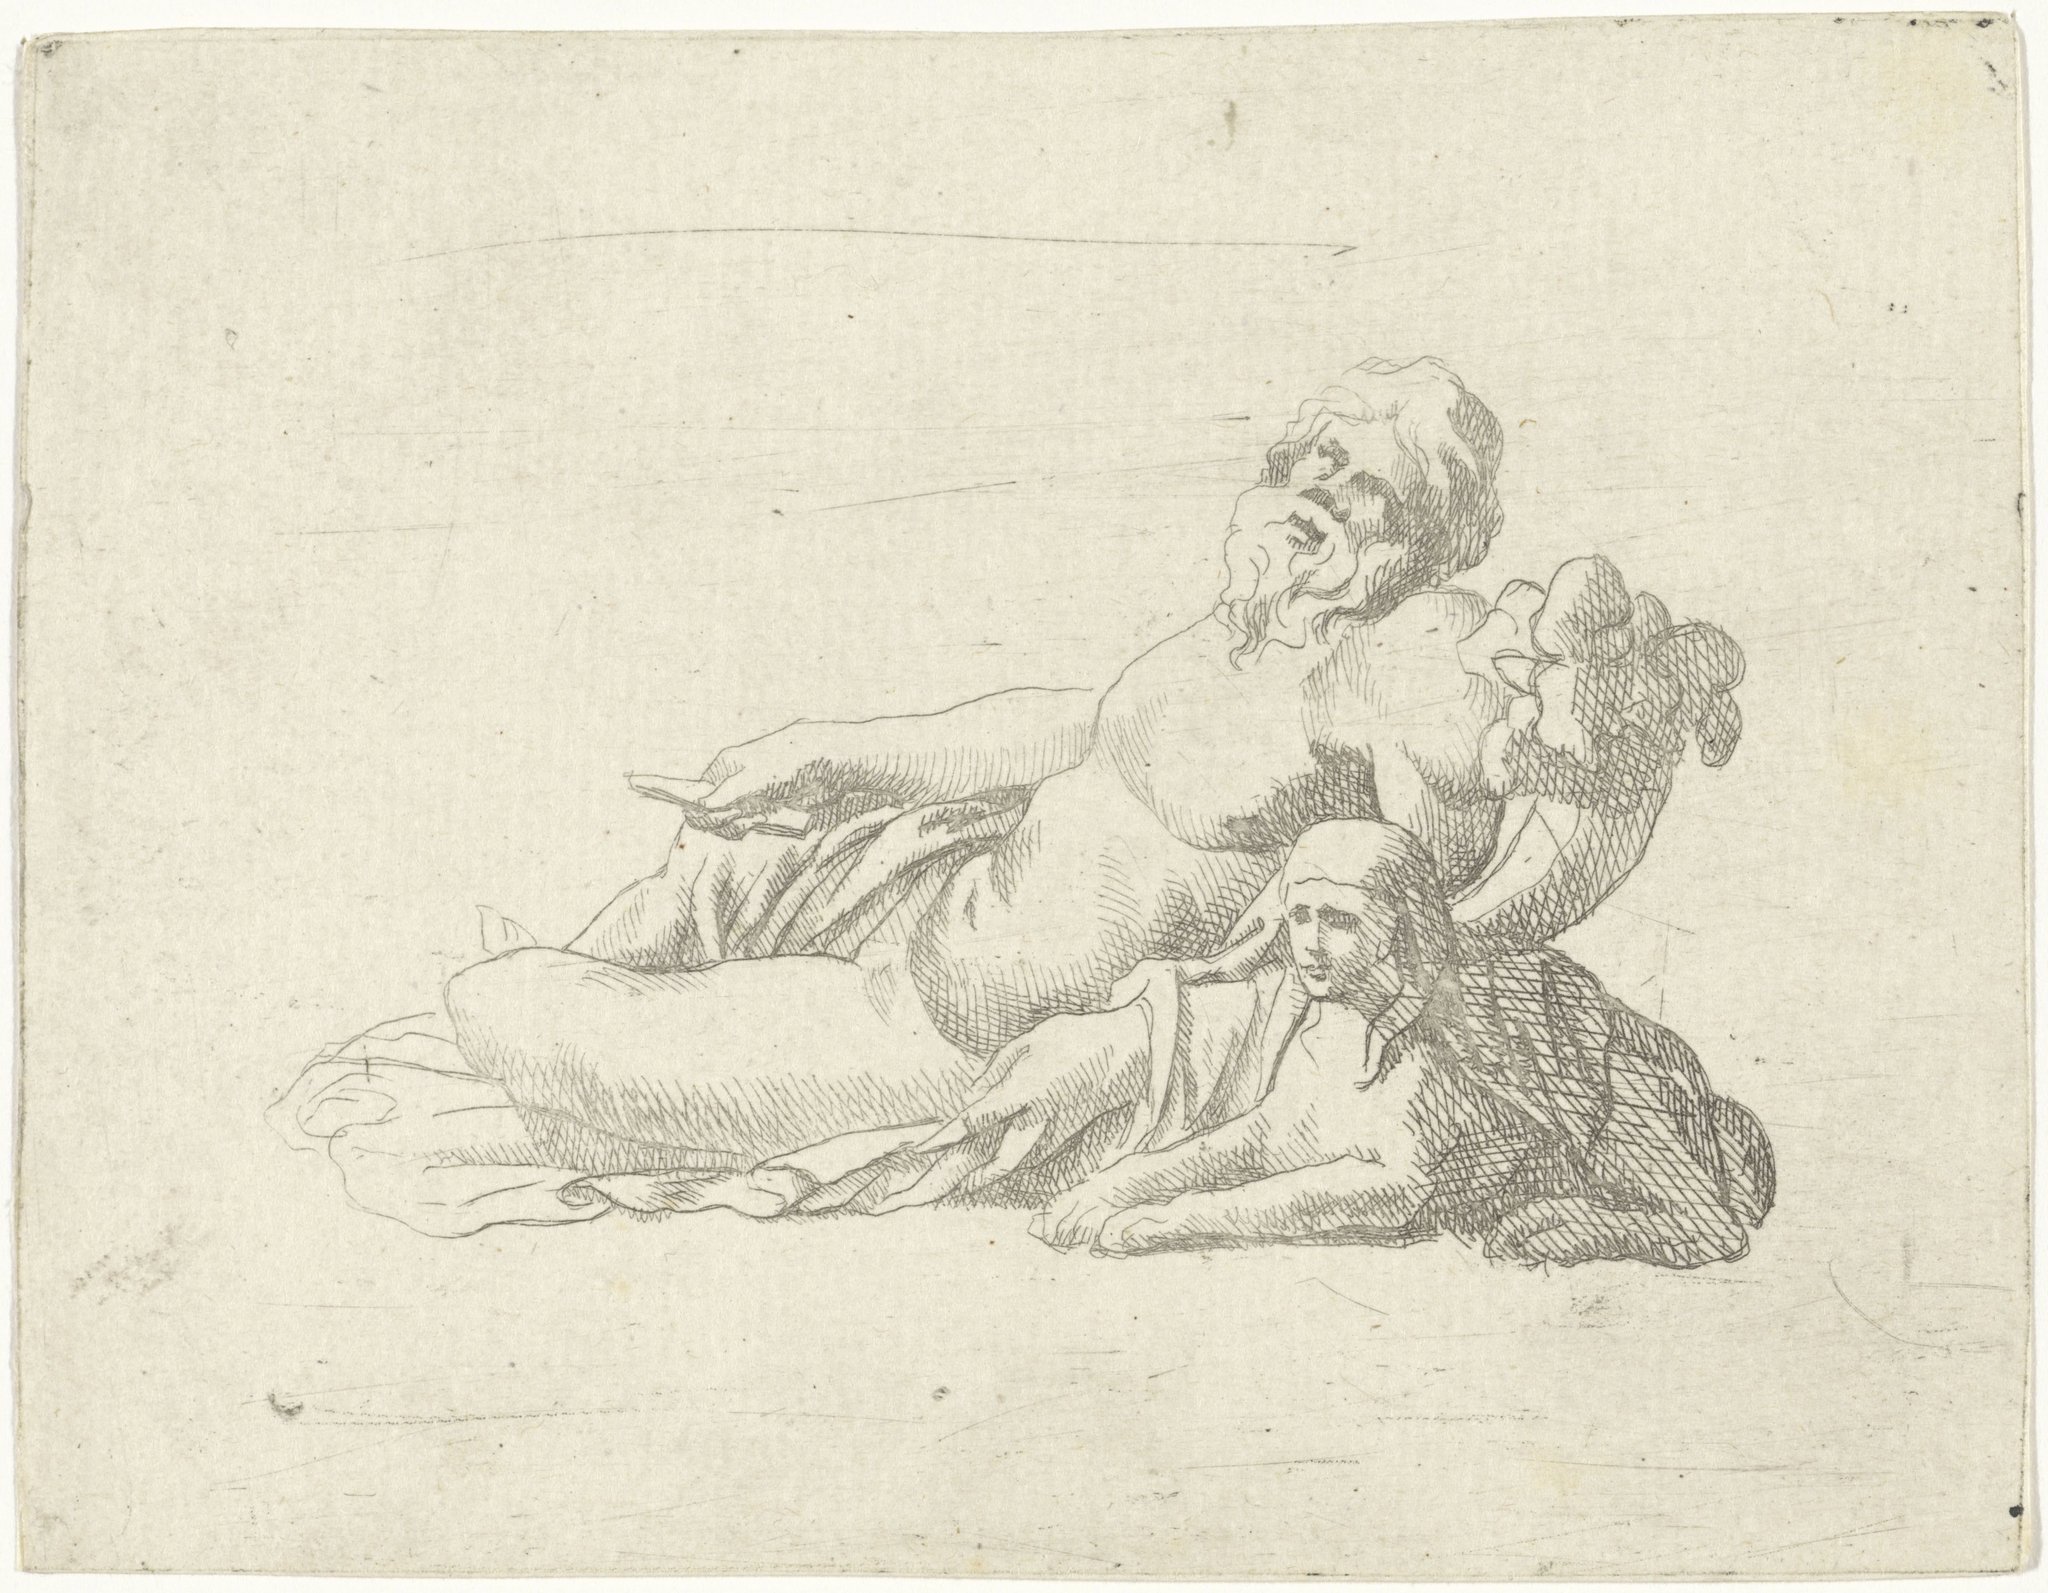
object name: print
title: Riviergod en sfinx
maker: jan verkolje (ii)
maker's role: print maker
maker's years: 1673-1755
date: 1683-1755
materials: paper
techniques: etching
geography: northern netherlands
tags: sphinx (lion/woman); 'sfinge' (ripa), river-gods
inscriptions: collector's mark: Lugt 240